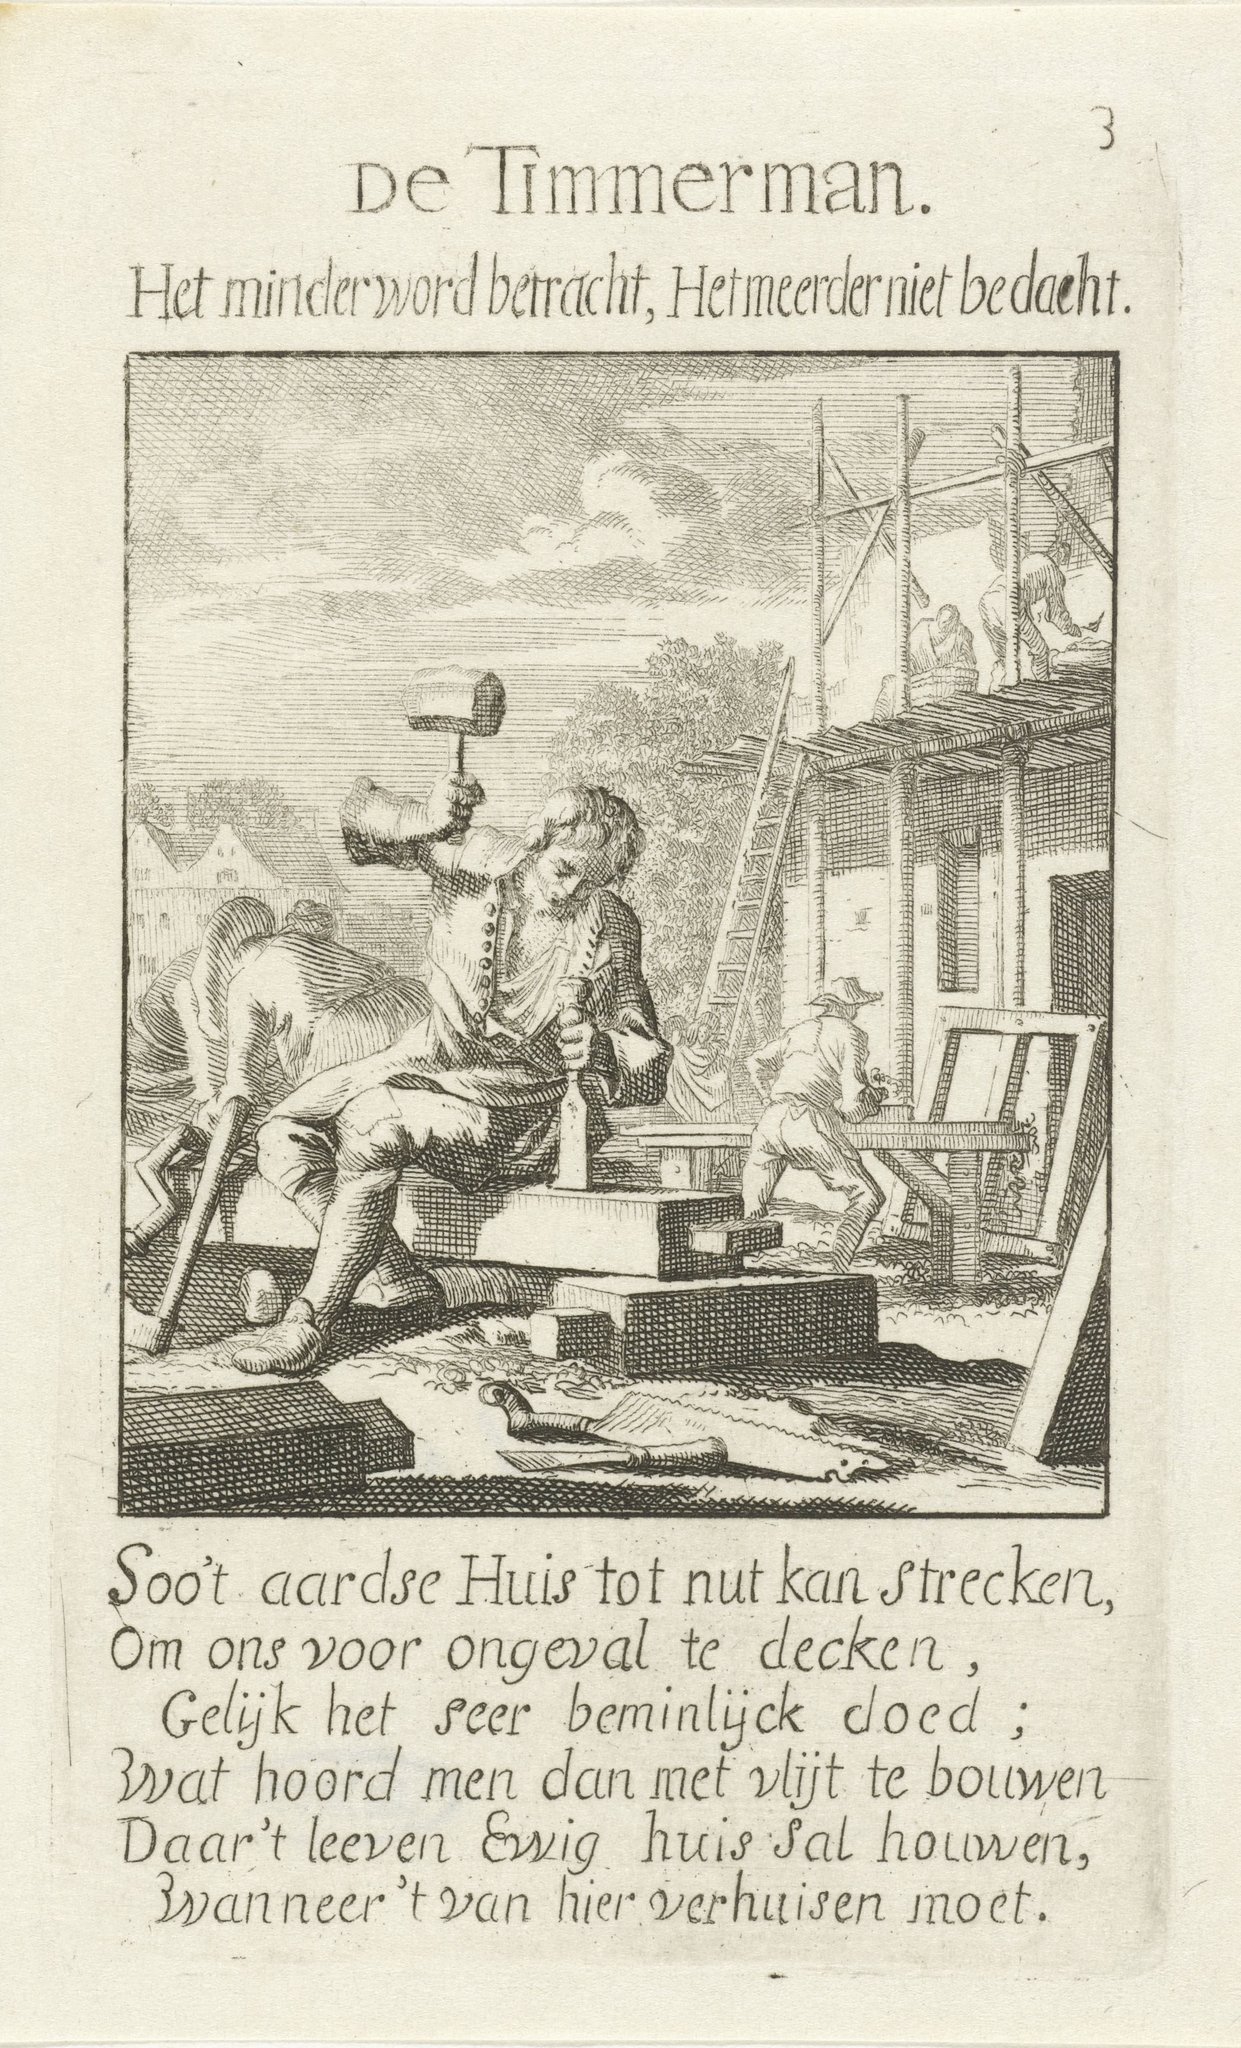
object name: print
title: Het Menselyk Bedryf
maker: jan luyken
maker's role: draughtsman, print maker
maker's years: 1649-1712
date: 1694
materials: paper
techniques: etching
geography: amsterdam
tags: carpenter, handicrafts, craftsman at work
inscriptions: collector's mark: Lugt 2228, collector's mark: Lugt 2760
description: Maakt deel uit van de 100-delige serie beroepsprenten van Jan en Caspar Luyken, getiteld: Het menselyk bedryf. S.l.s.n., 1694 (eerste druk).